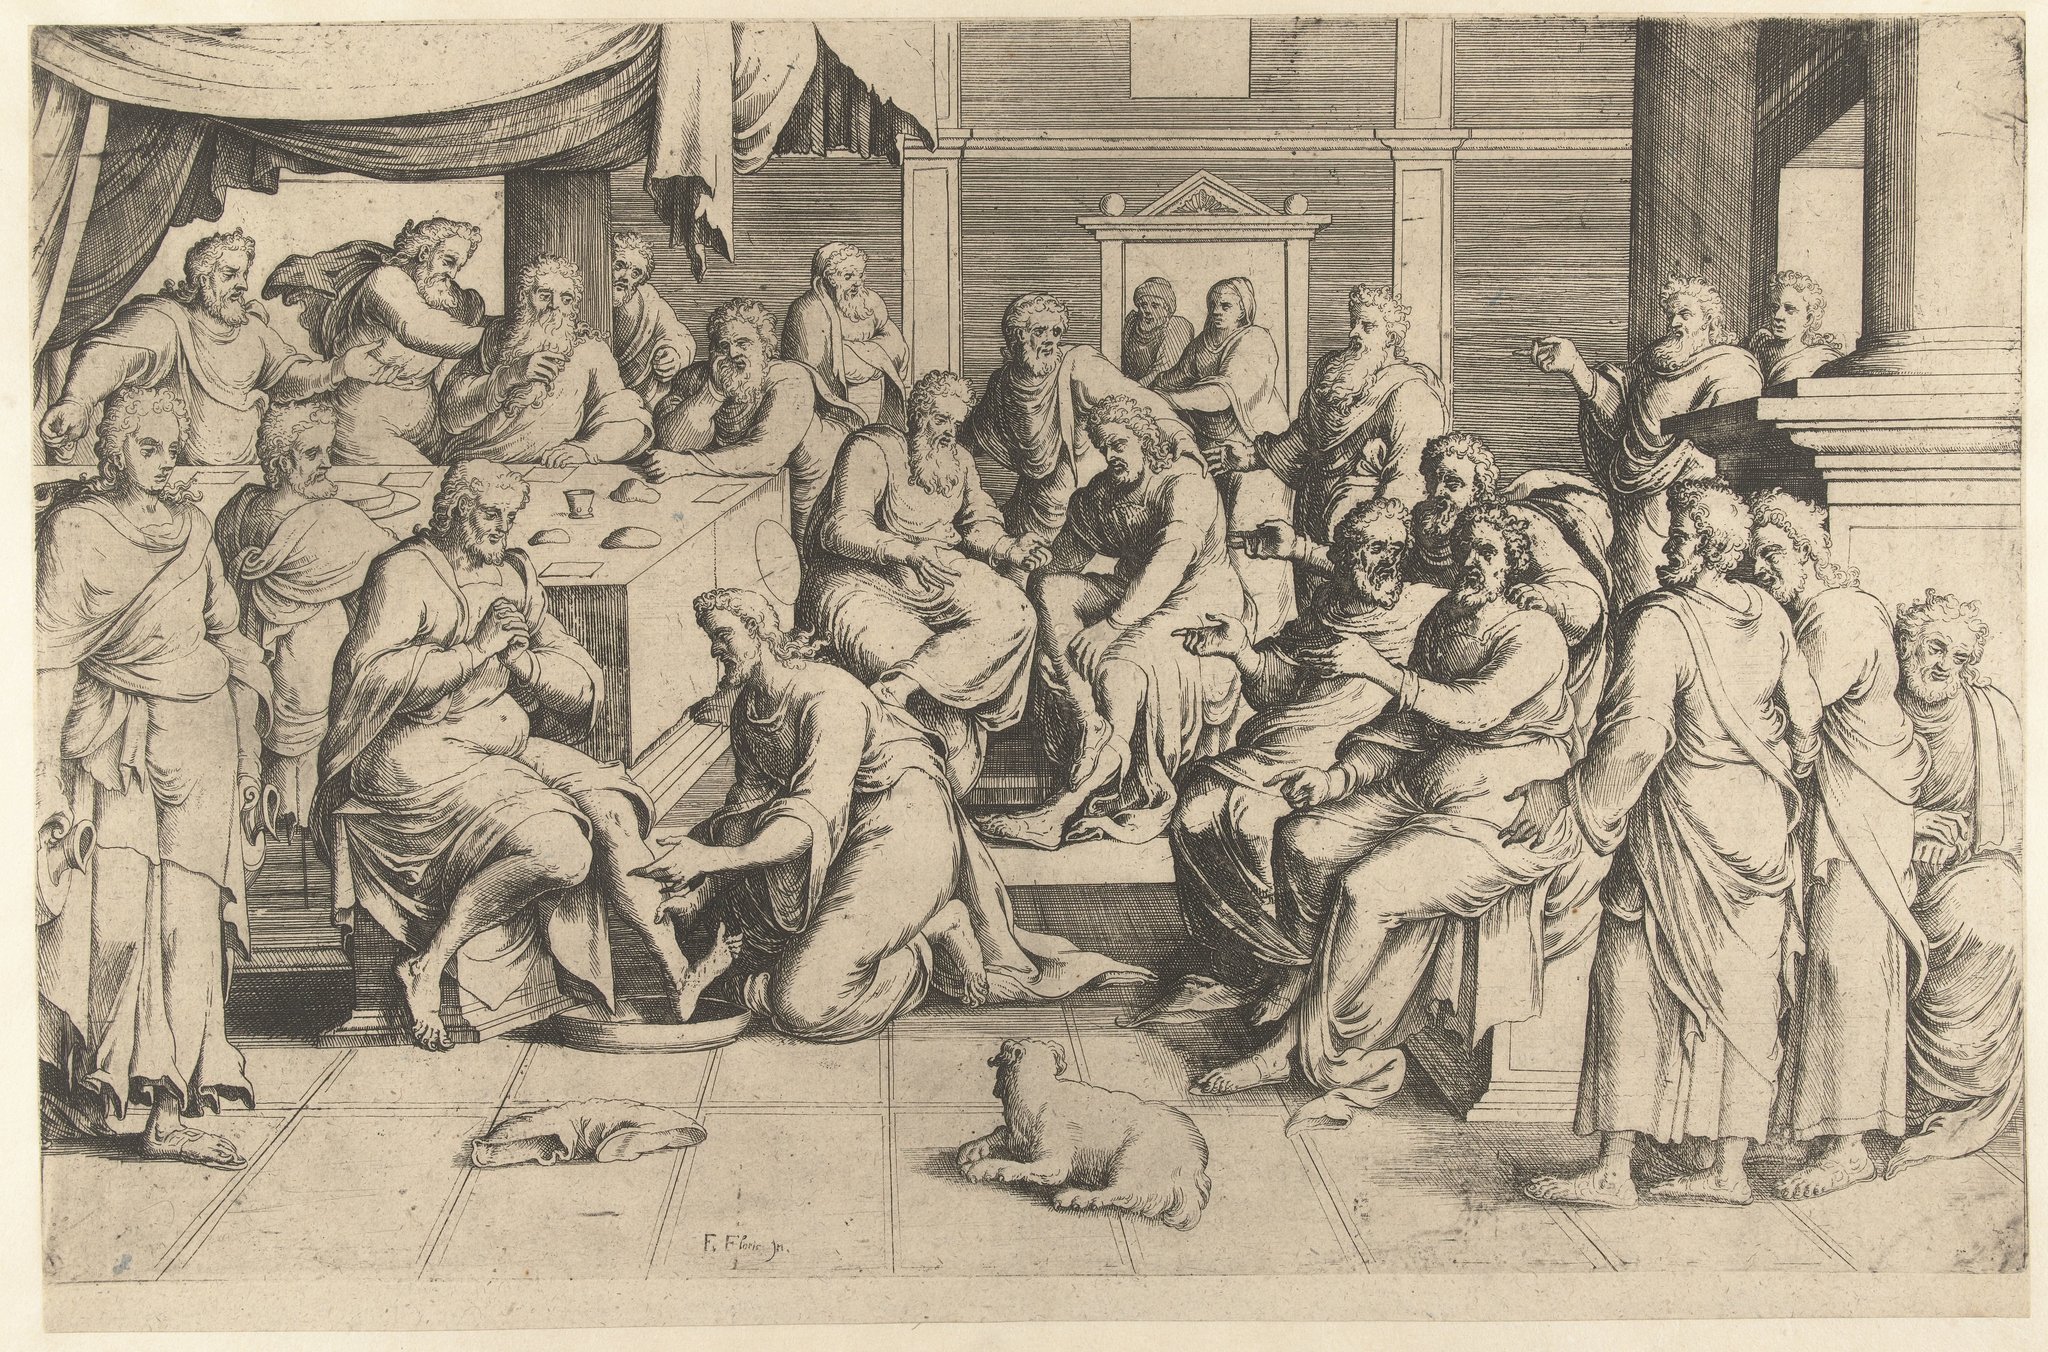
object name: print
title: De voetwassing van Petrus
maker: frans floris (i)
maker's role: draughtsman, print maker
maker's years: 1519-1570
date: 1534-1570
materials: paper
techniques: engraving, etching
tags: christ washes peter's feet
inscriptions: collector's mark: Lugt 2228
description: De discipel Petrus wast de voet van Christus.